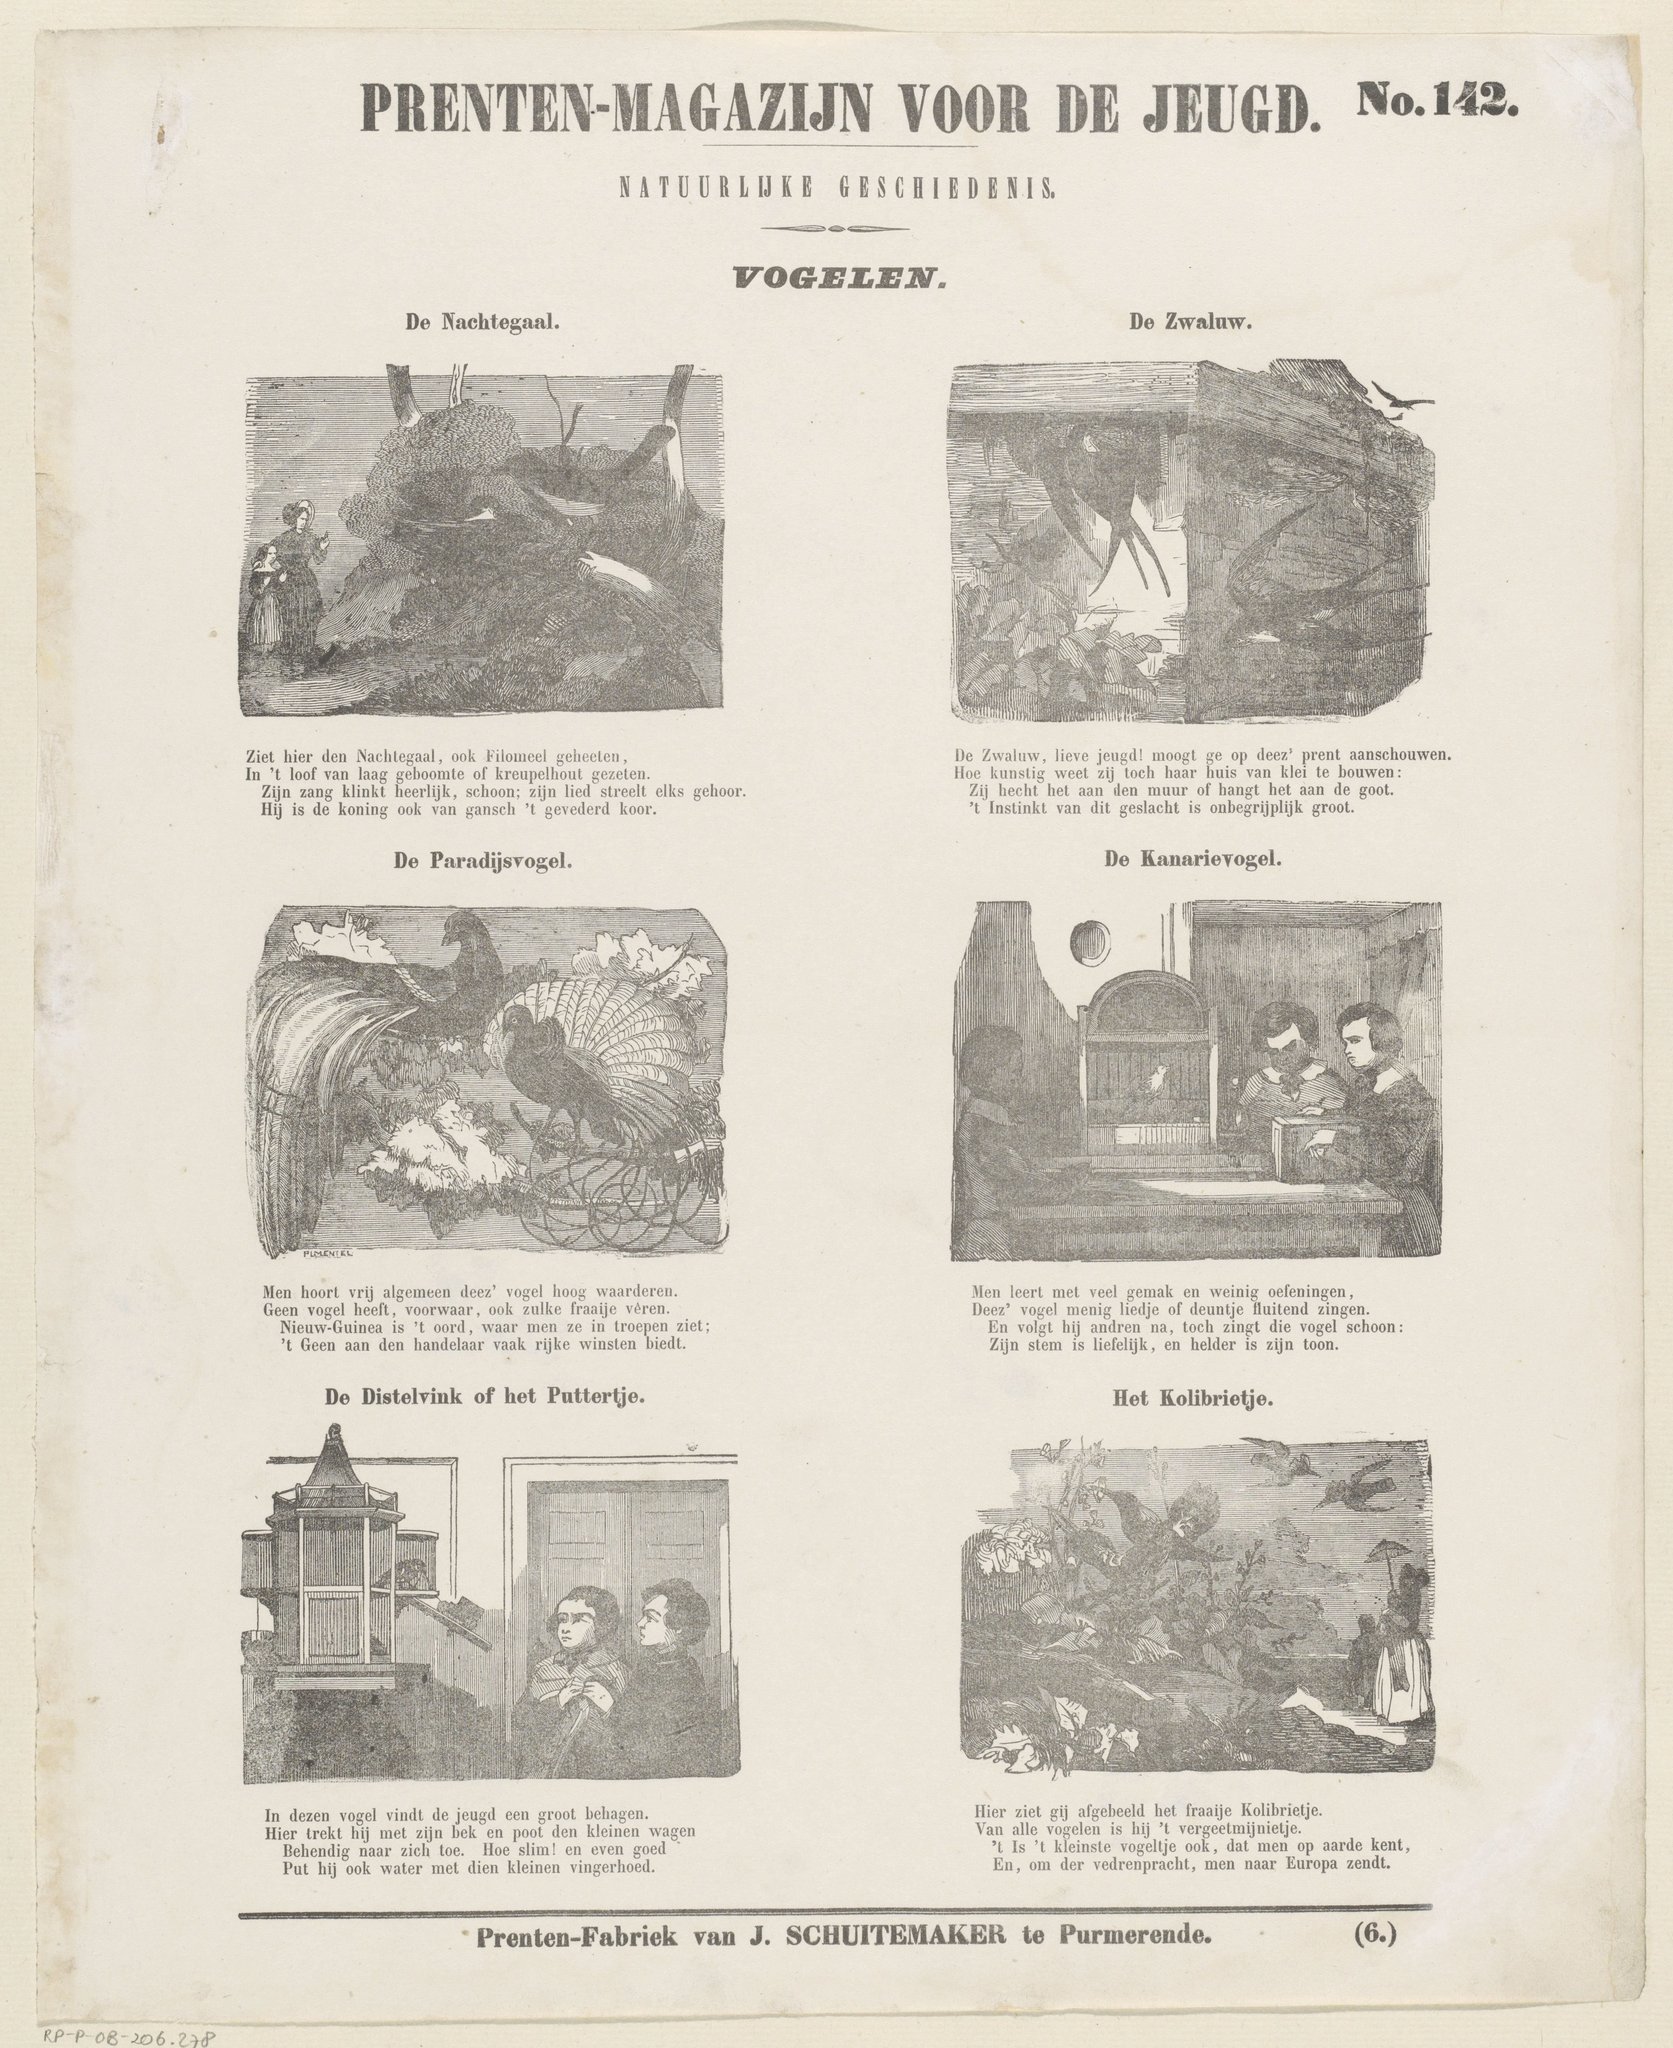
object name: popular print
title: Prenten-magazijn voor de jeugd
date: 1850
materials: paper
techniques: letterpress printing, engraving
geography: netherlands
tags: other birds (with name), birds, song-birds: swallow, ornamental birds: bird of paradise, song-birds: nightingale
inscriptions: collector's mark: Lugt 2760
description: Na voltooiing van de acht jaargangen van de reeks 'Prenten-magazijn voor de jeugd' in 1850 heeft Jan Schuitemaker al deze prenten heruitgegeven en omgenummerd als nr. 1 t/m 192. De oorspronkelijke jaargang wordt telkens nog vermeld rechtsonder op de prent. Binnen de jaargangen zijn prenten van hetzelfde thema in clusters van vier achter elkaar gezet.